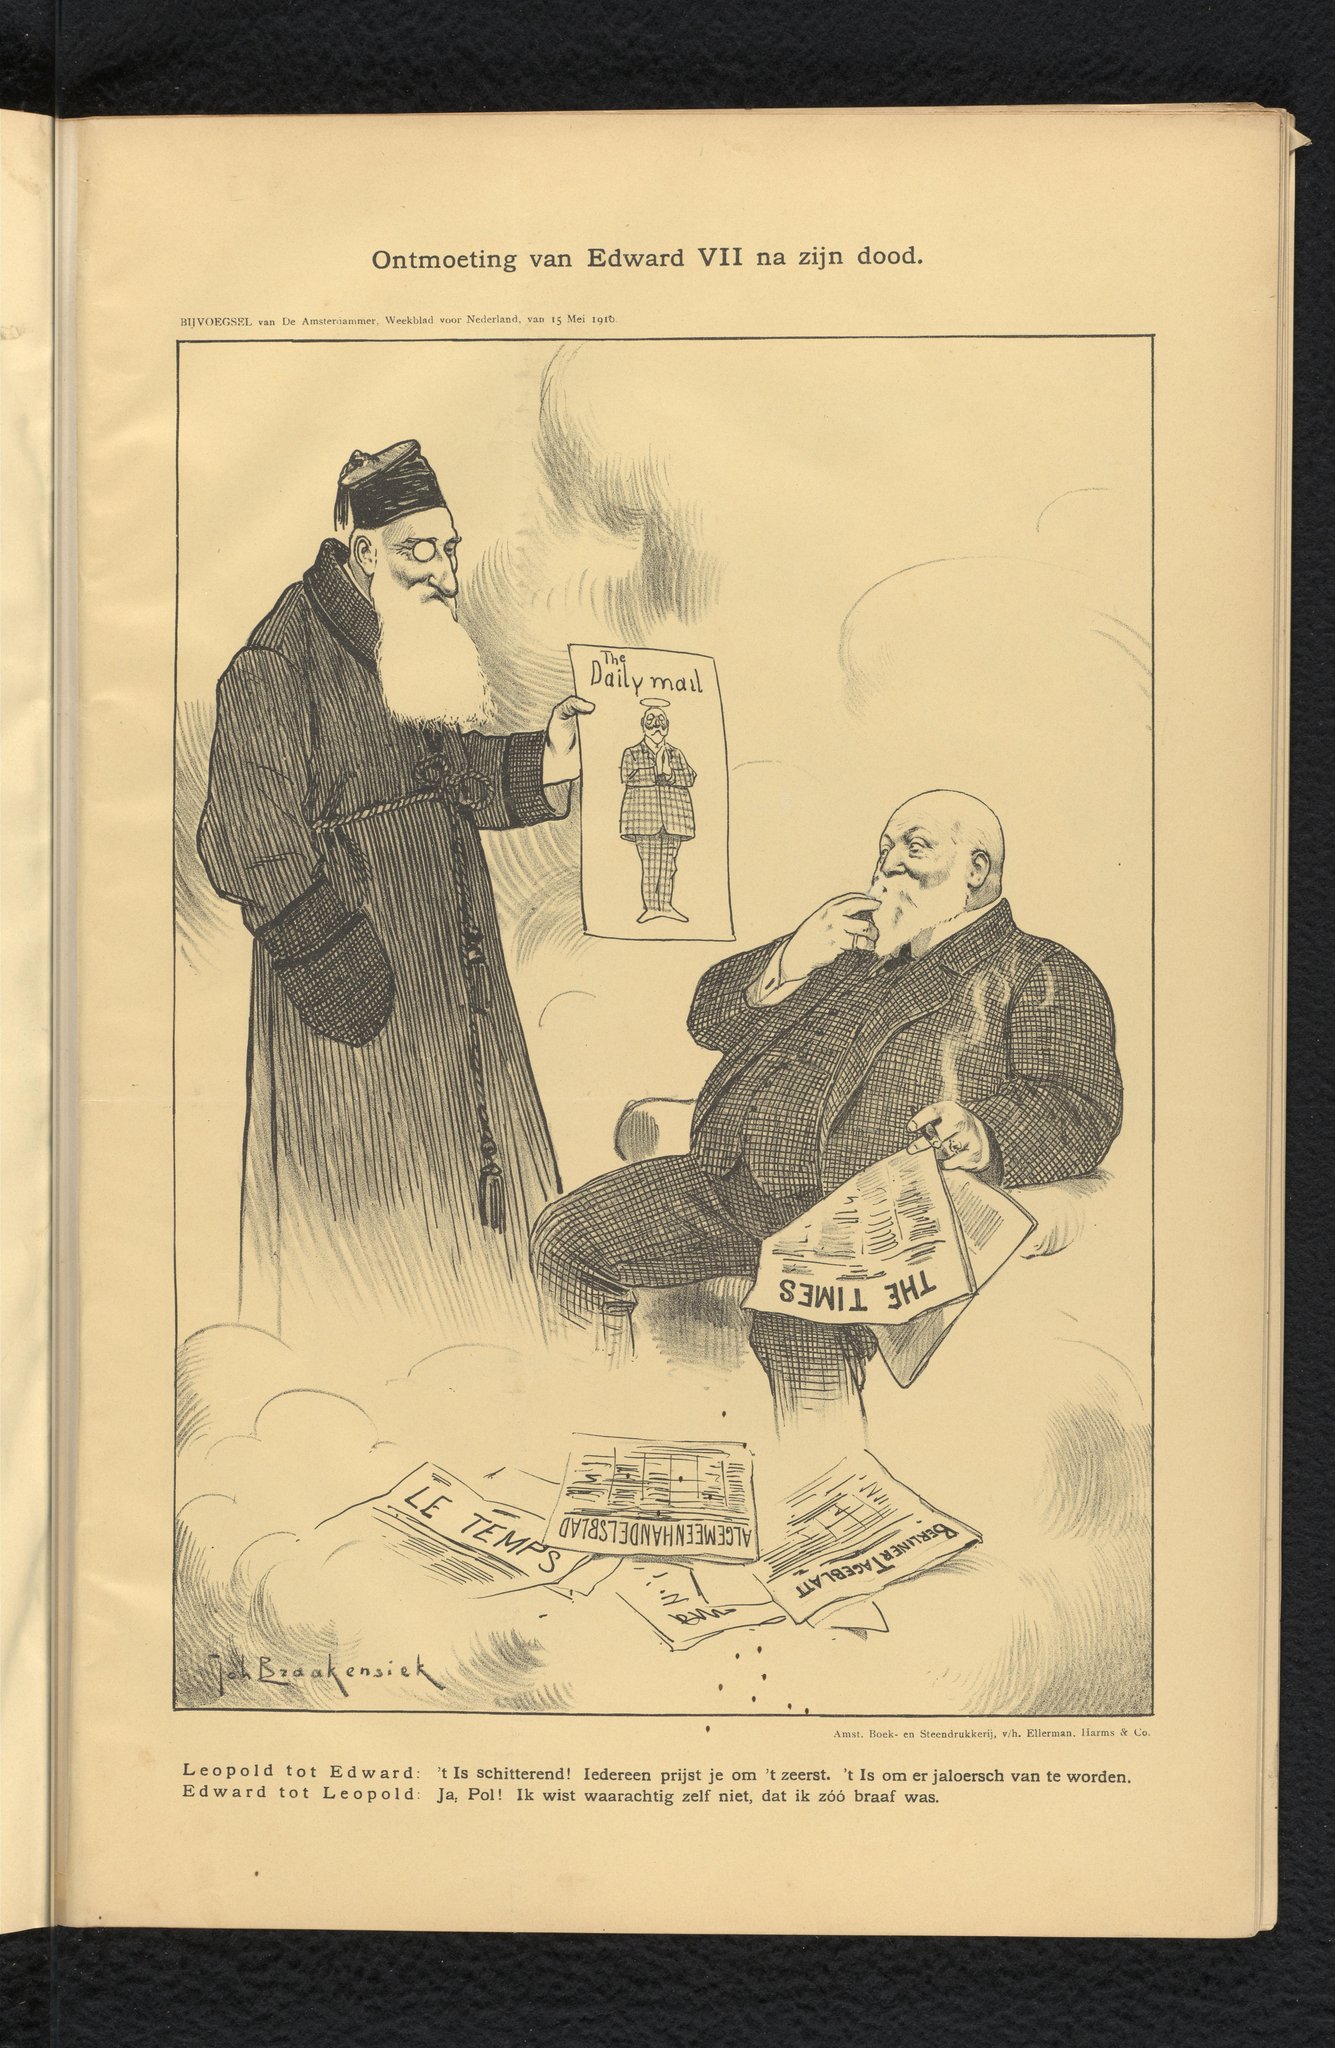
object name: cartoon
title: Ontmoeting van Edward VII na zijn dood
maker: johan braakensiek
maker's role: draughtsman, print maker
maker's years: 1858-1940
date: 1910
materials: paper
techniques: lithograph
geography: netherlands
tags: leopold ii (koning der belgen), newspaper, news-sheet, political caricatures and satires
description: De al eerder overleden Belgische koning Leopold II op bezoek bij de op 6 mei overleden Engelse koning Edward VII. Tot hun beider verrassing blijkt er positief over Edward geschreven in de kranten.